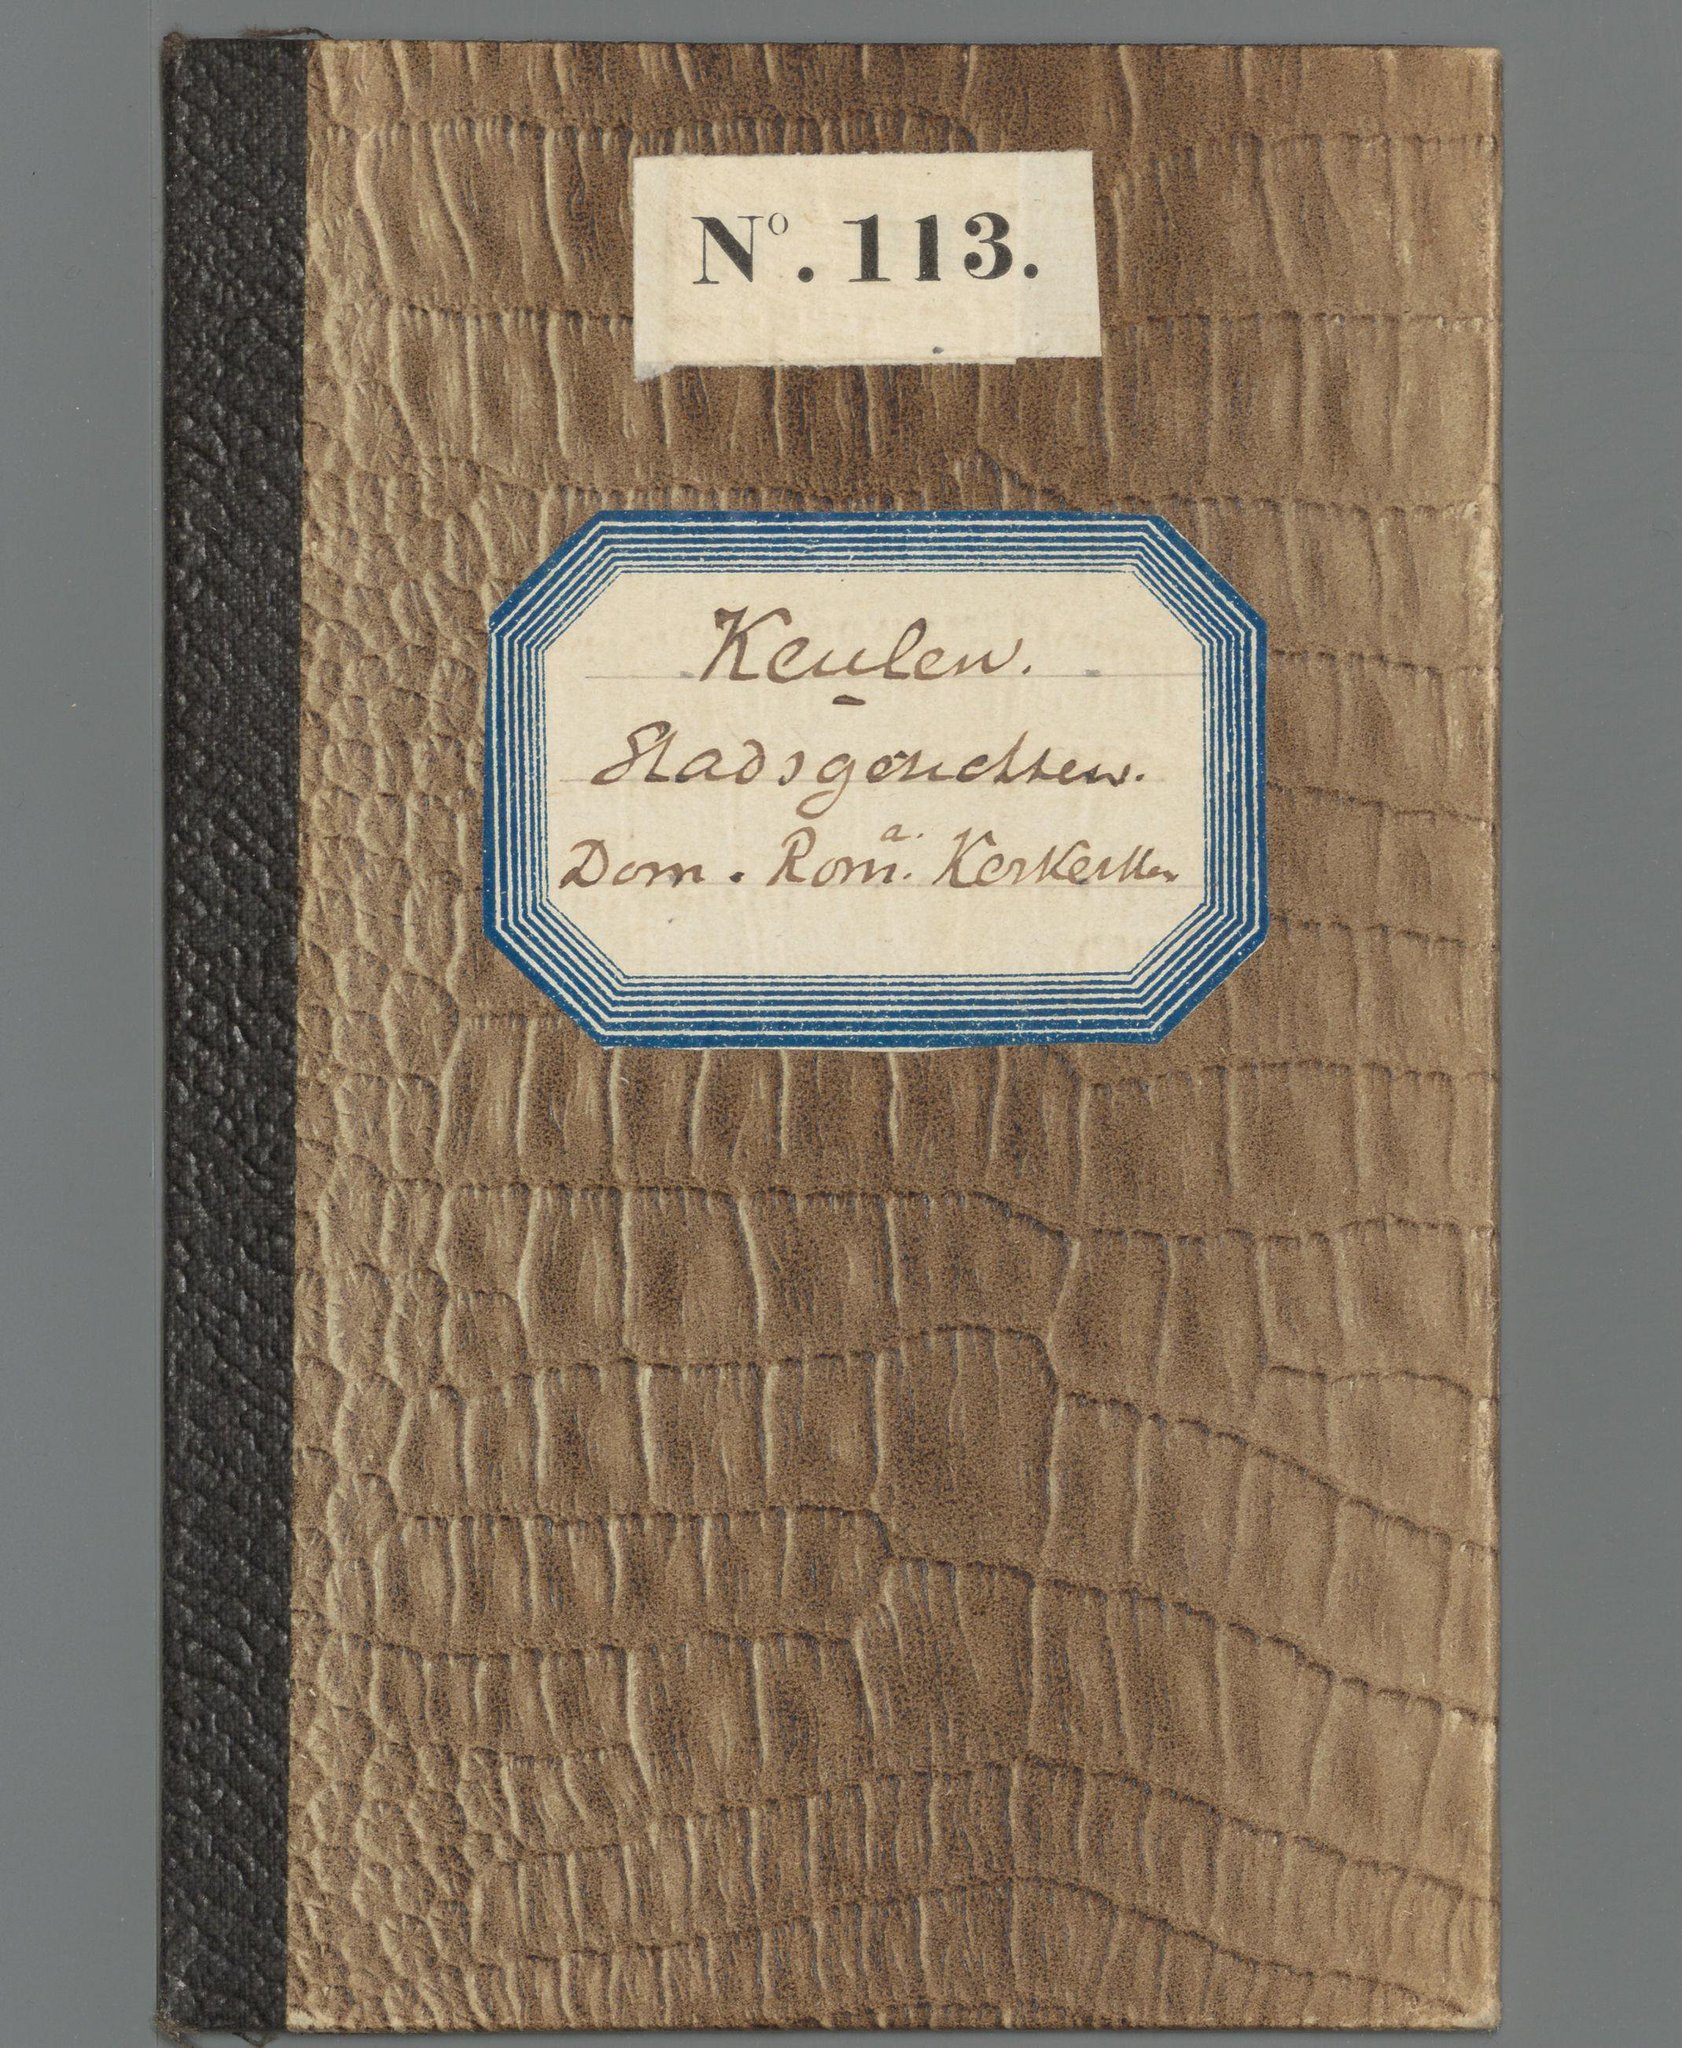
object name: wrapper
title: Keulen. Stadsgezichten. Dom. Rom. Kerkeulen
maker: Anonymous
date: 1900-1950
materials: cardboard, paper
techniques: lithograph, writing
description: In de omslag zit een kaart ingestoken met daarop een korte beschrijving van de inhoud.